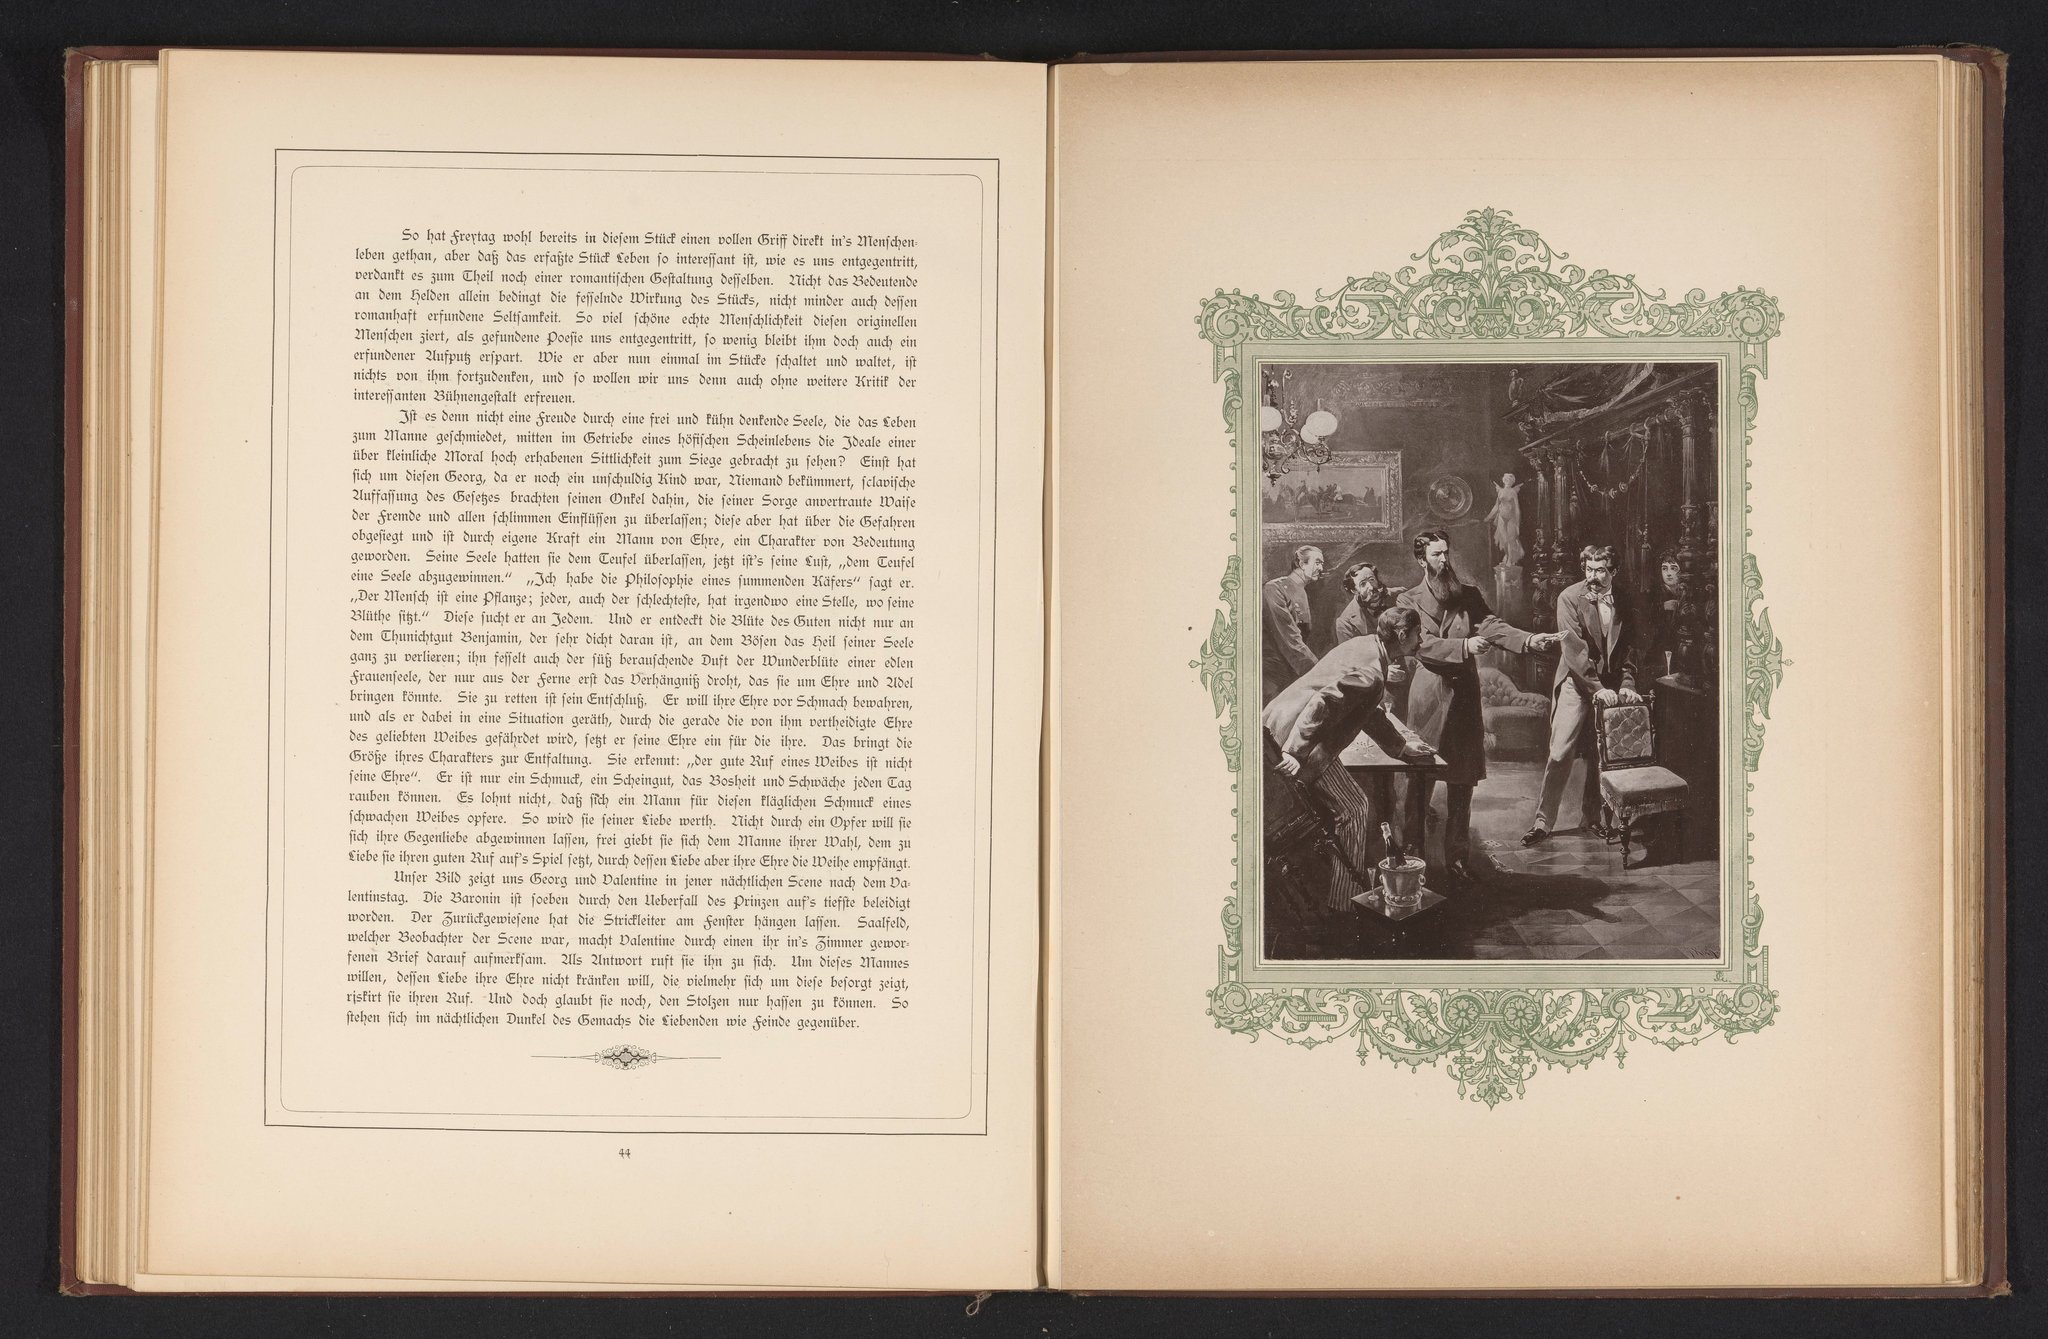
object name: reproduction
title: Fotoreproductie van een schilderij voorstellende graaf Waldemar en vier andere mannen uit Soll und Haben door Gustav Freytag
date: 1877-1882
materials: paper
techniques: photograph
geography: germany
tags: adult man, interior of the house